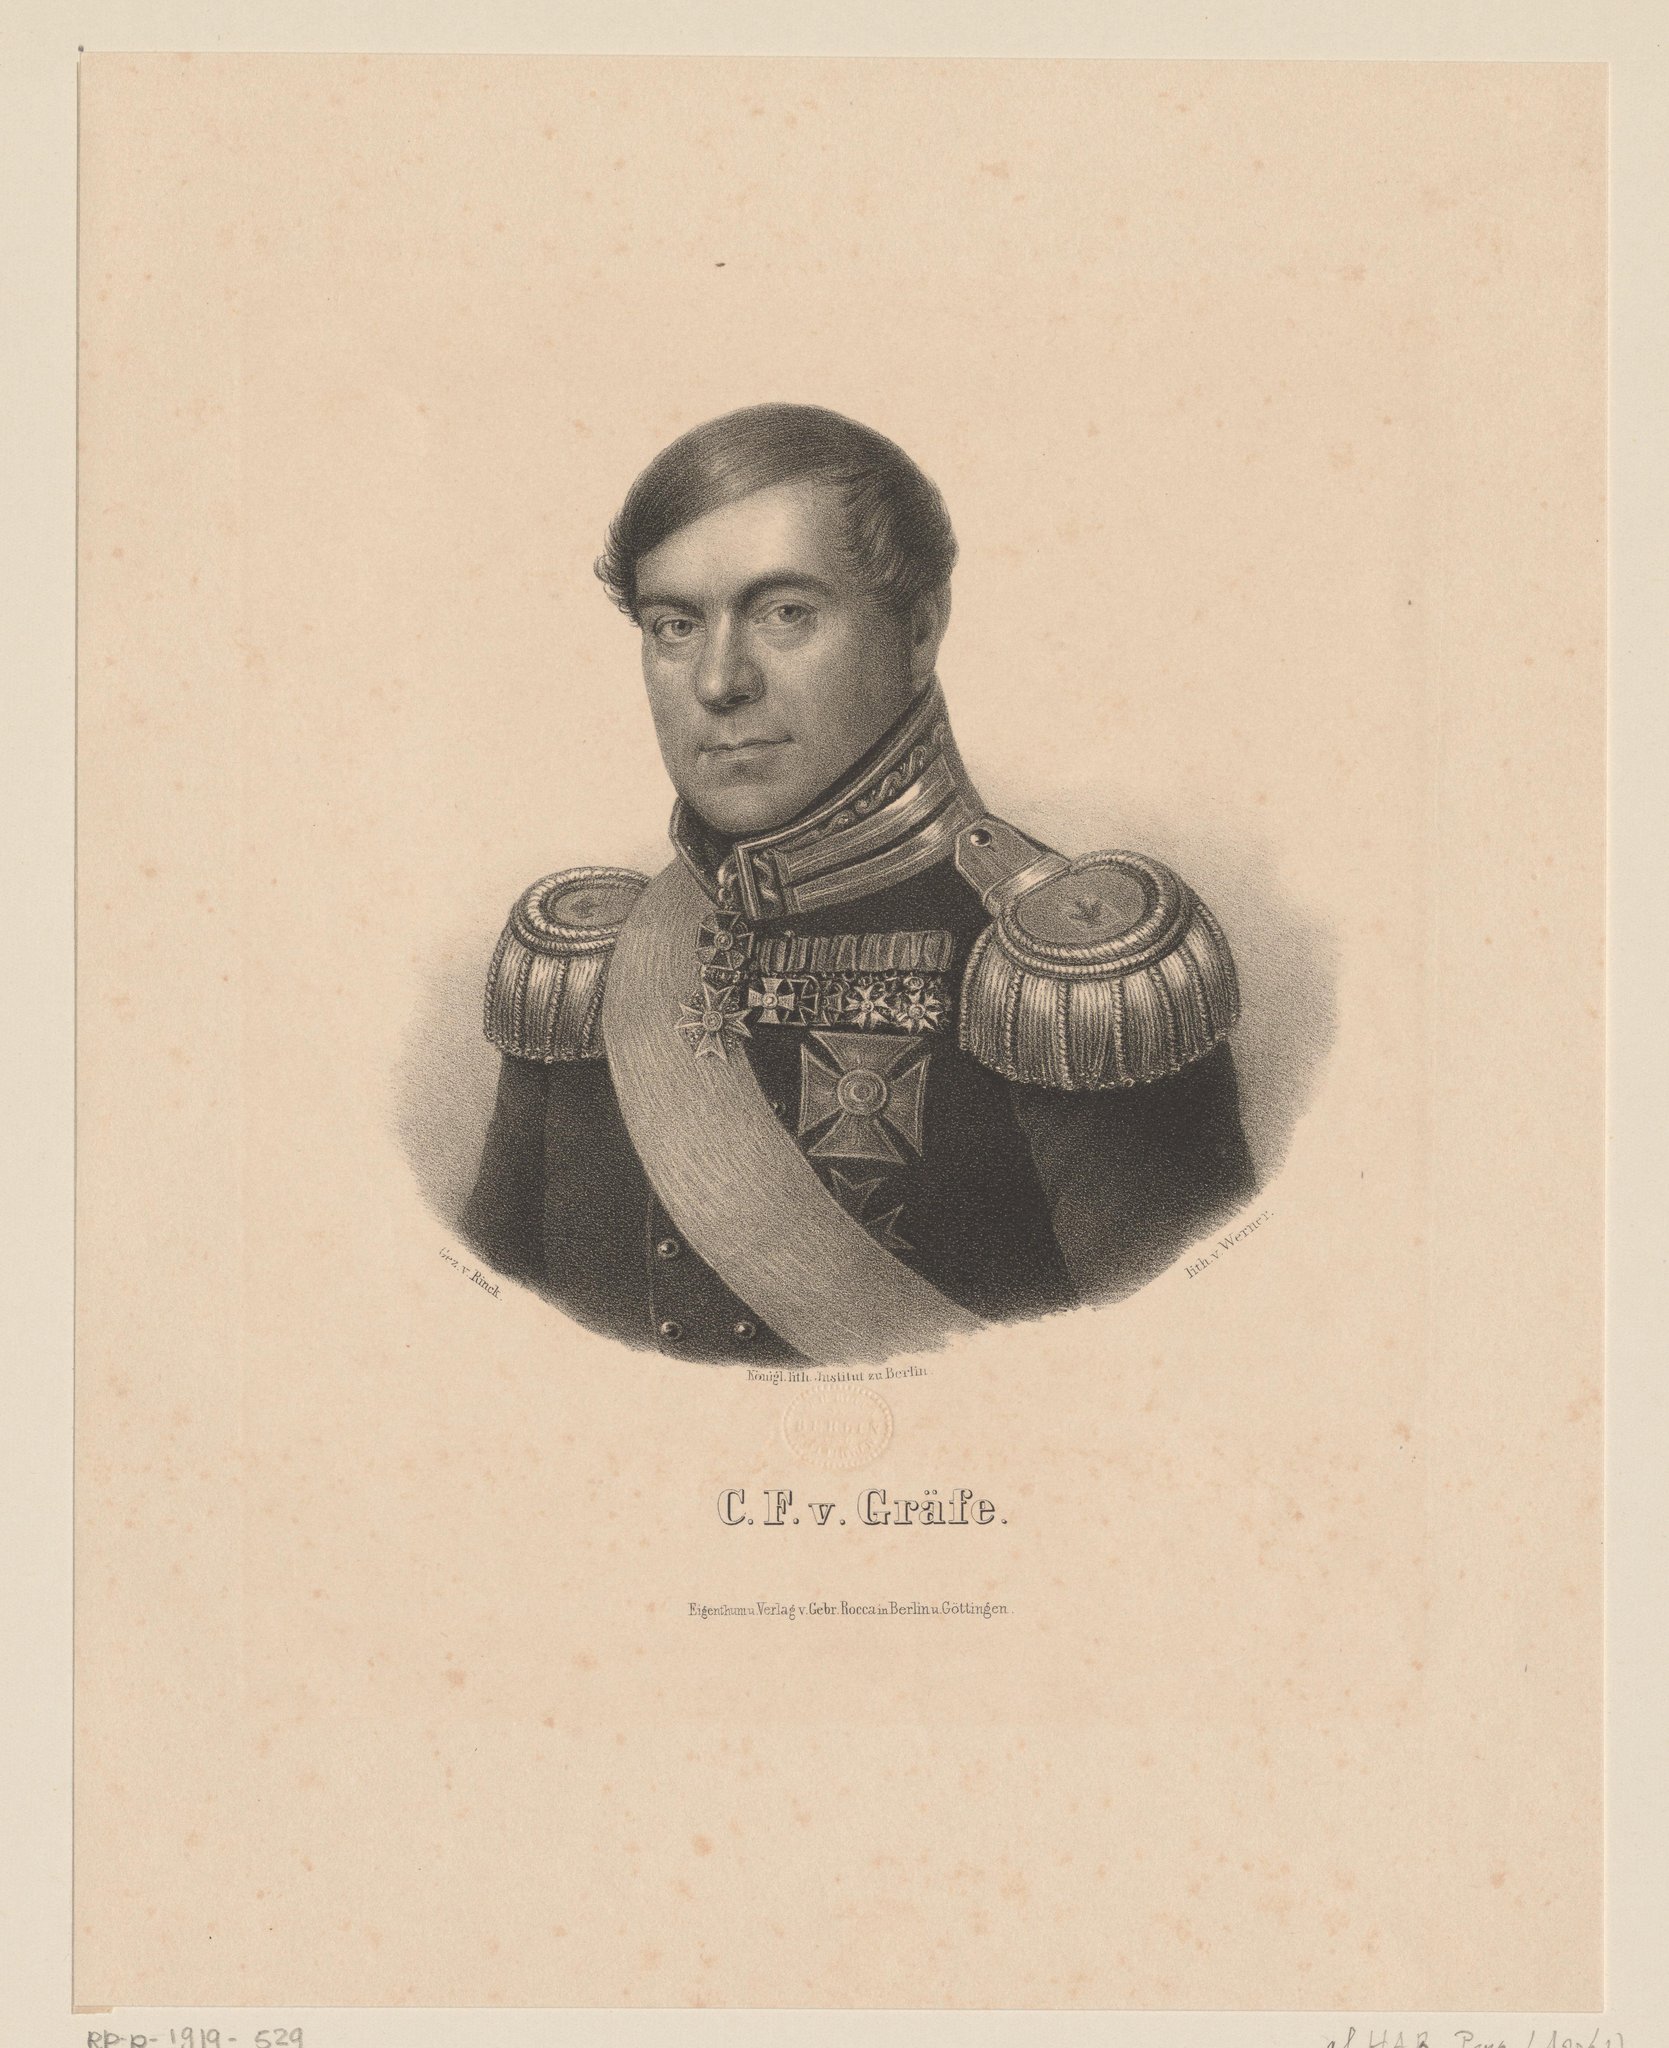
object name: print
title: Portret van Karl Ferdinand von Gräfe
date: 1850-1861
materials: paper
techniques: lithograph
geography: berlin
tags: karl ferdinand von gräfe, historical persons, physician, doctor (+ portrait of scholar, scientist), professor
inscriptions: collector's mark: Lugt 2228